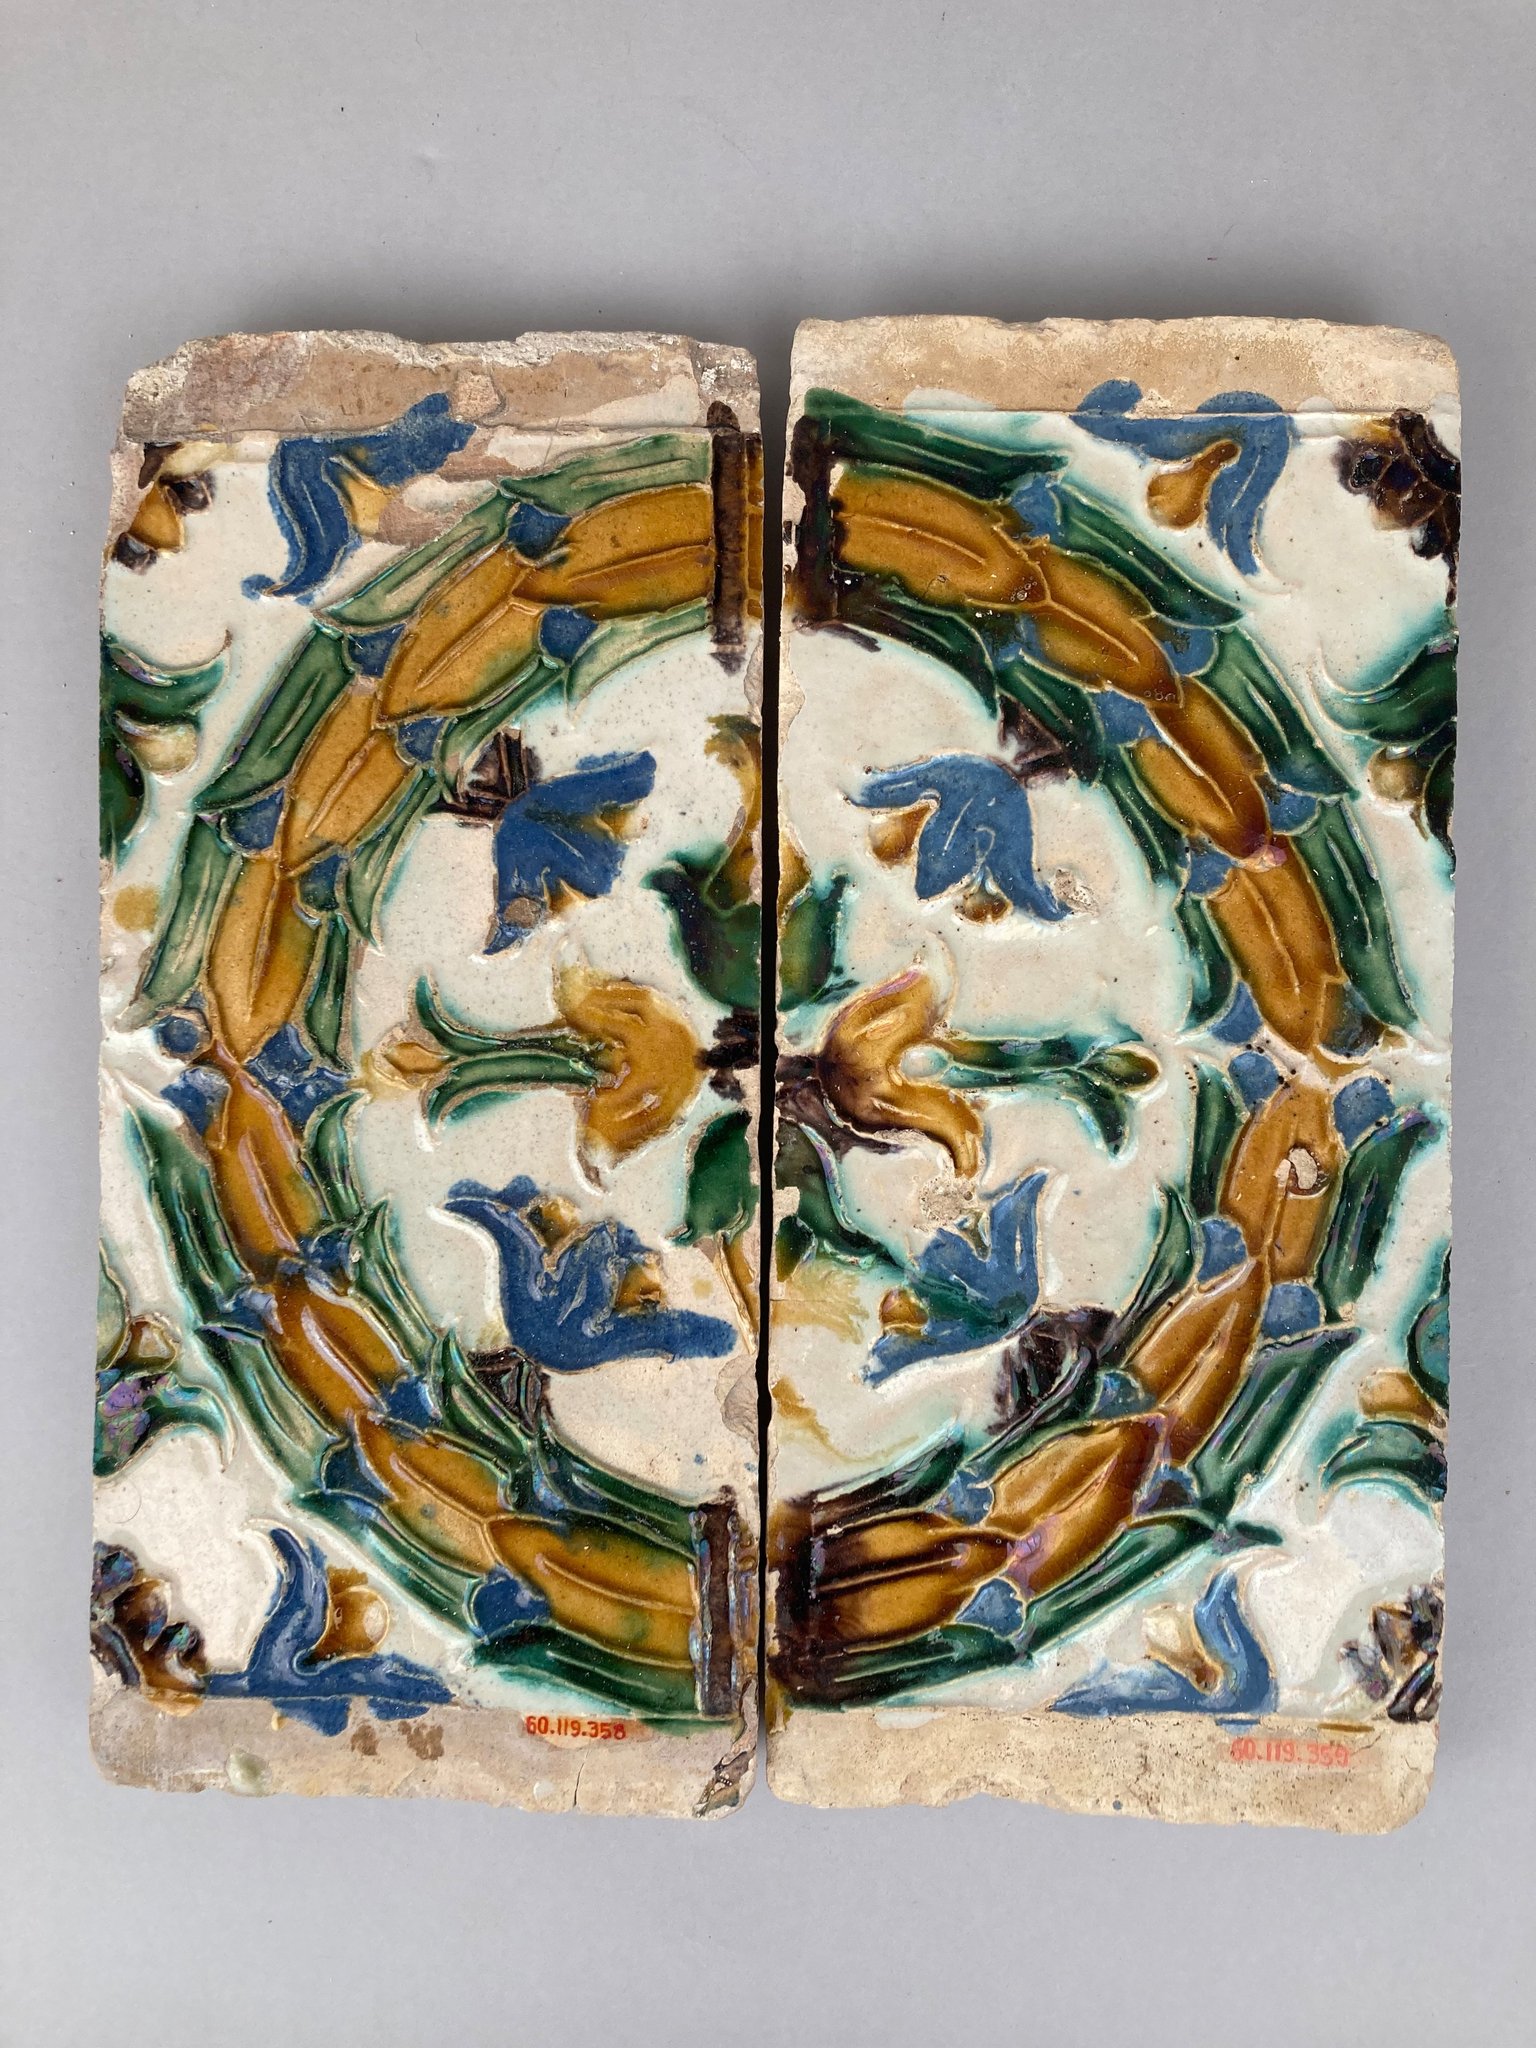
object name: ceiling tile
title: Ceiling tiles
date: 1534-1566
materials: earthenware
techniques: glazing